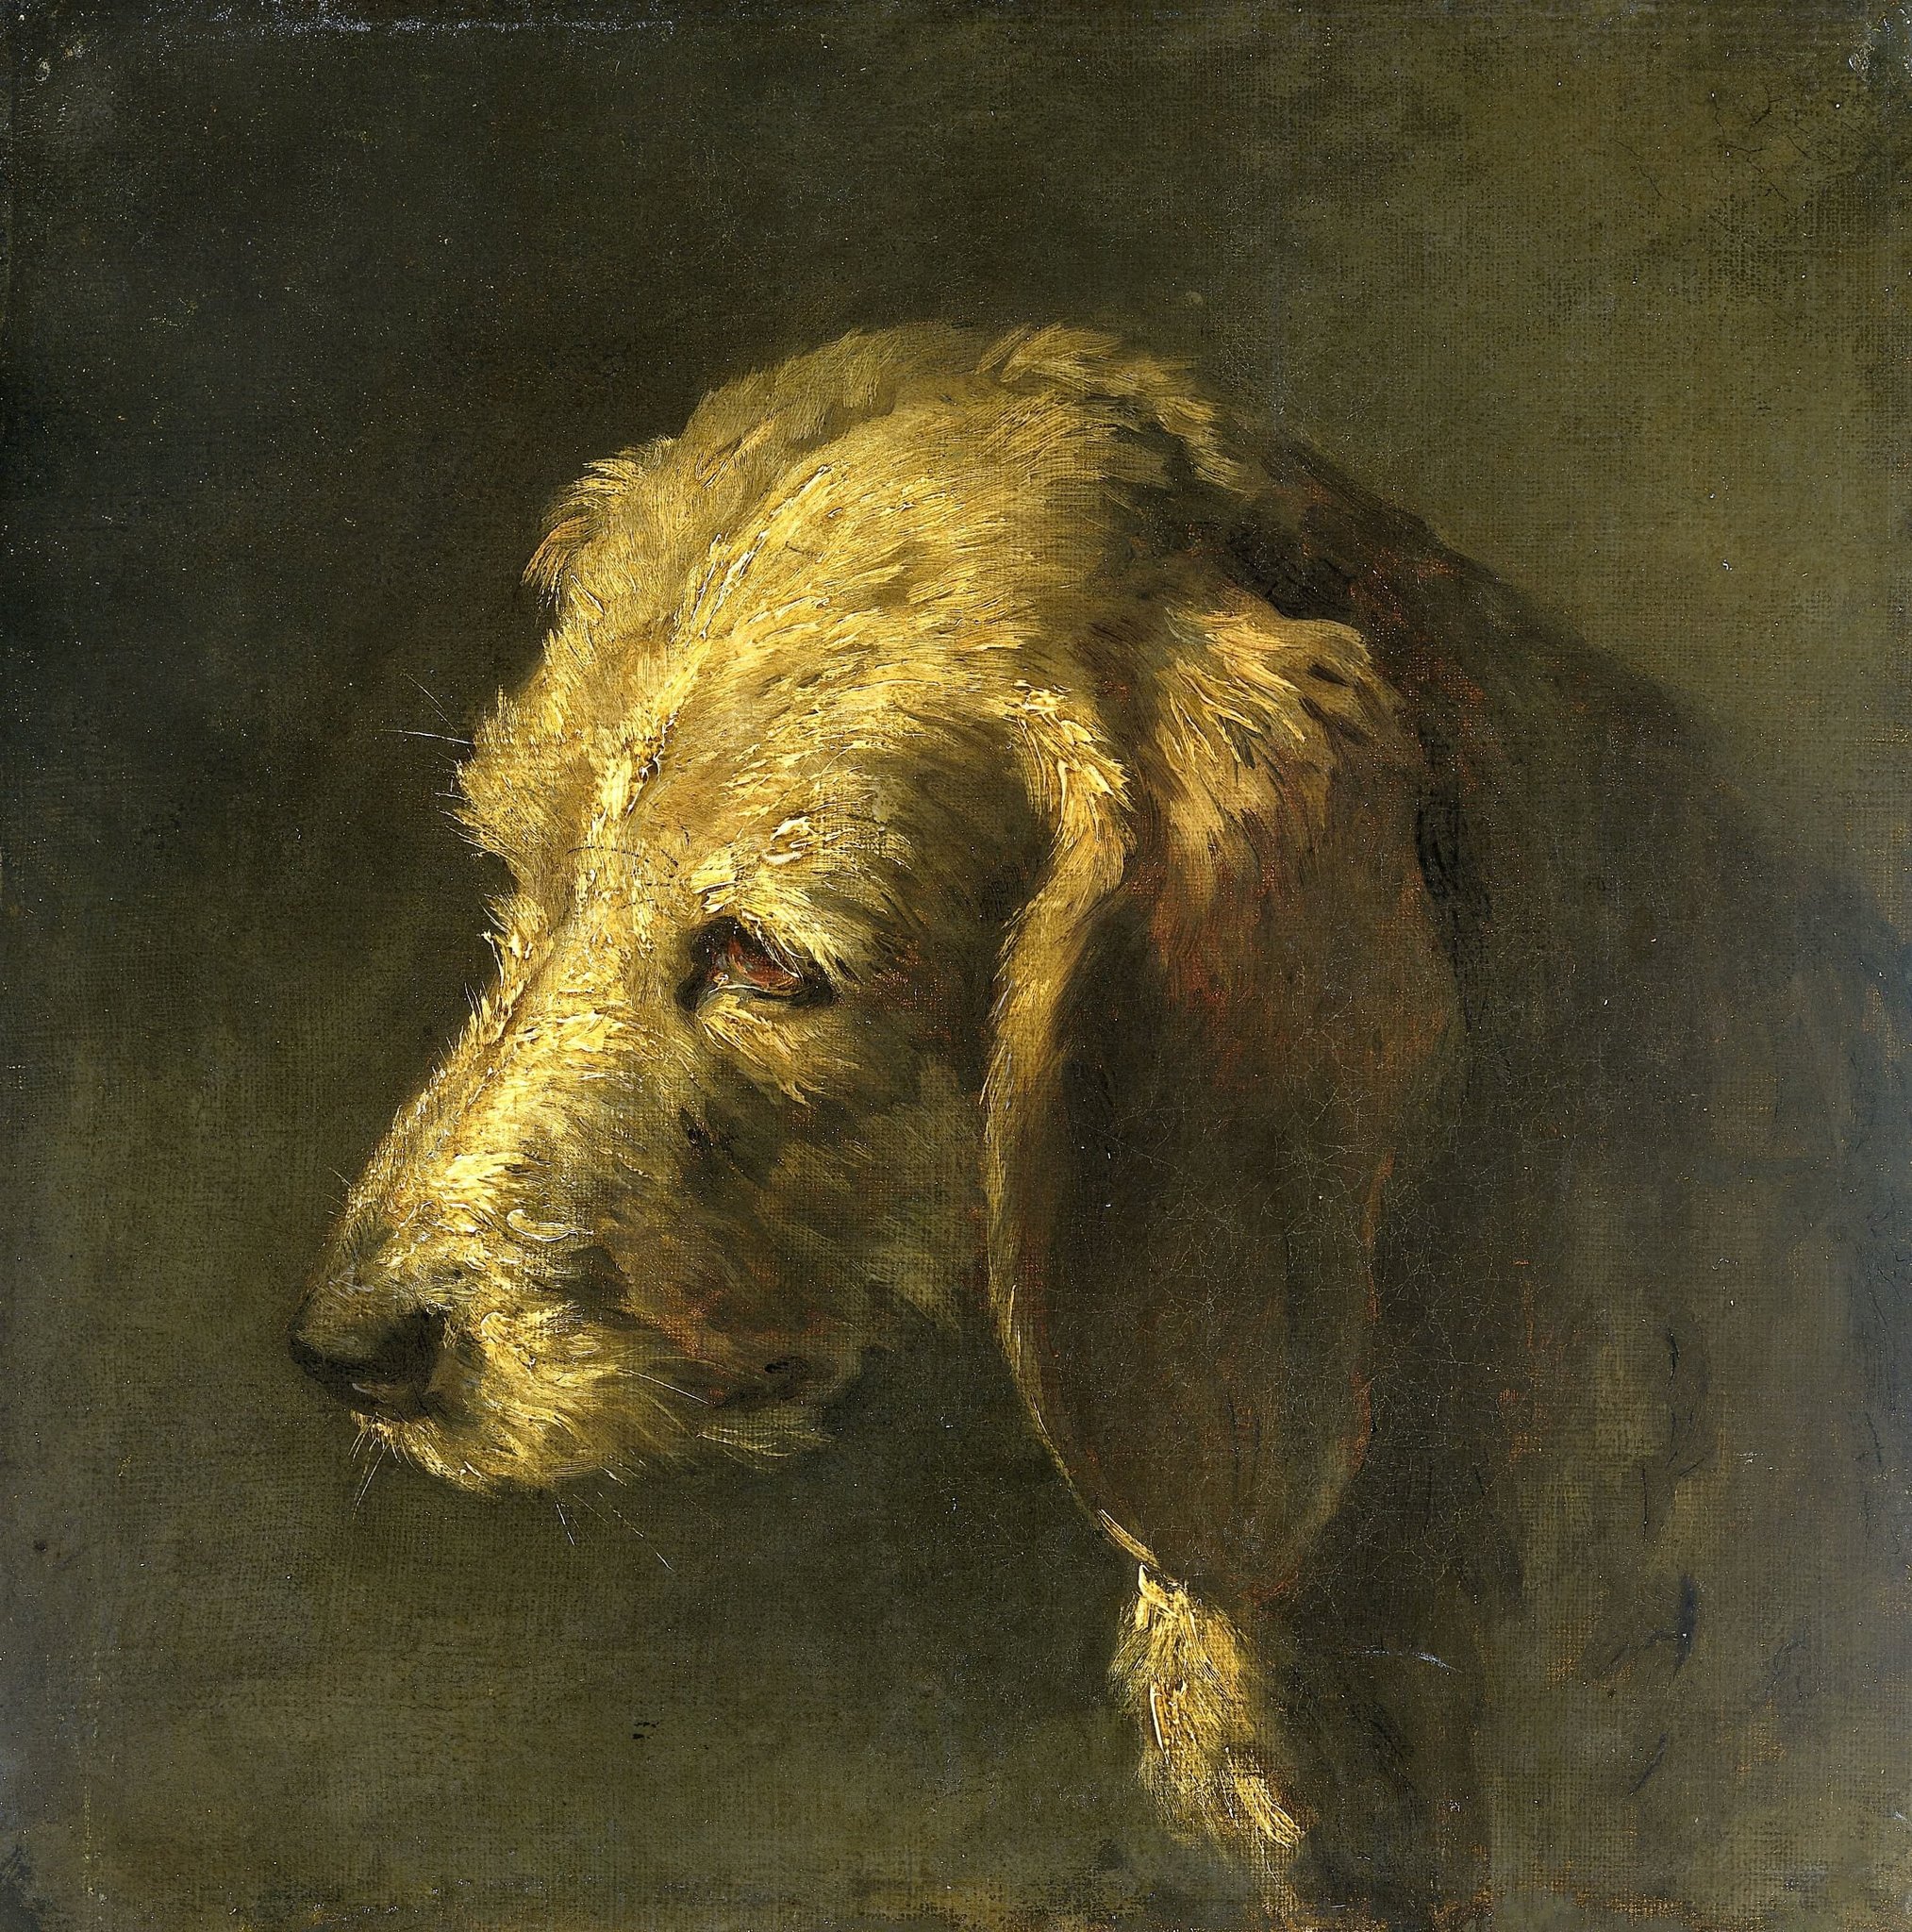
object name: painting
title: Head of a Dog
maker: nicolas toussaint charlet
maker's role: draughtsman, painter, print maker, printer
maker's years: 1792-1845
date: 1820-1845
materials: canvas, oil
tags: dog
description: Hondenkop. Kop van een hond, profiel naar links.